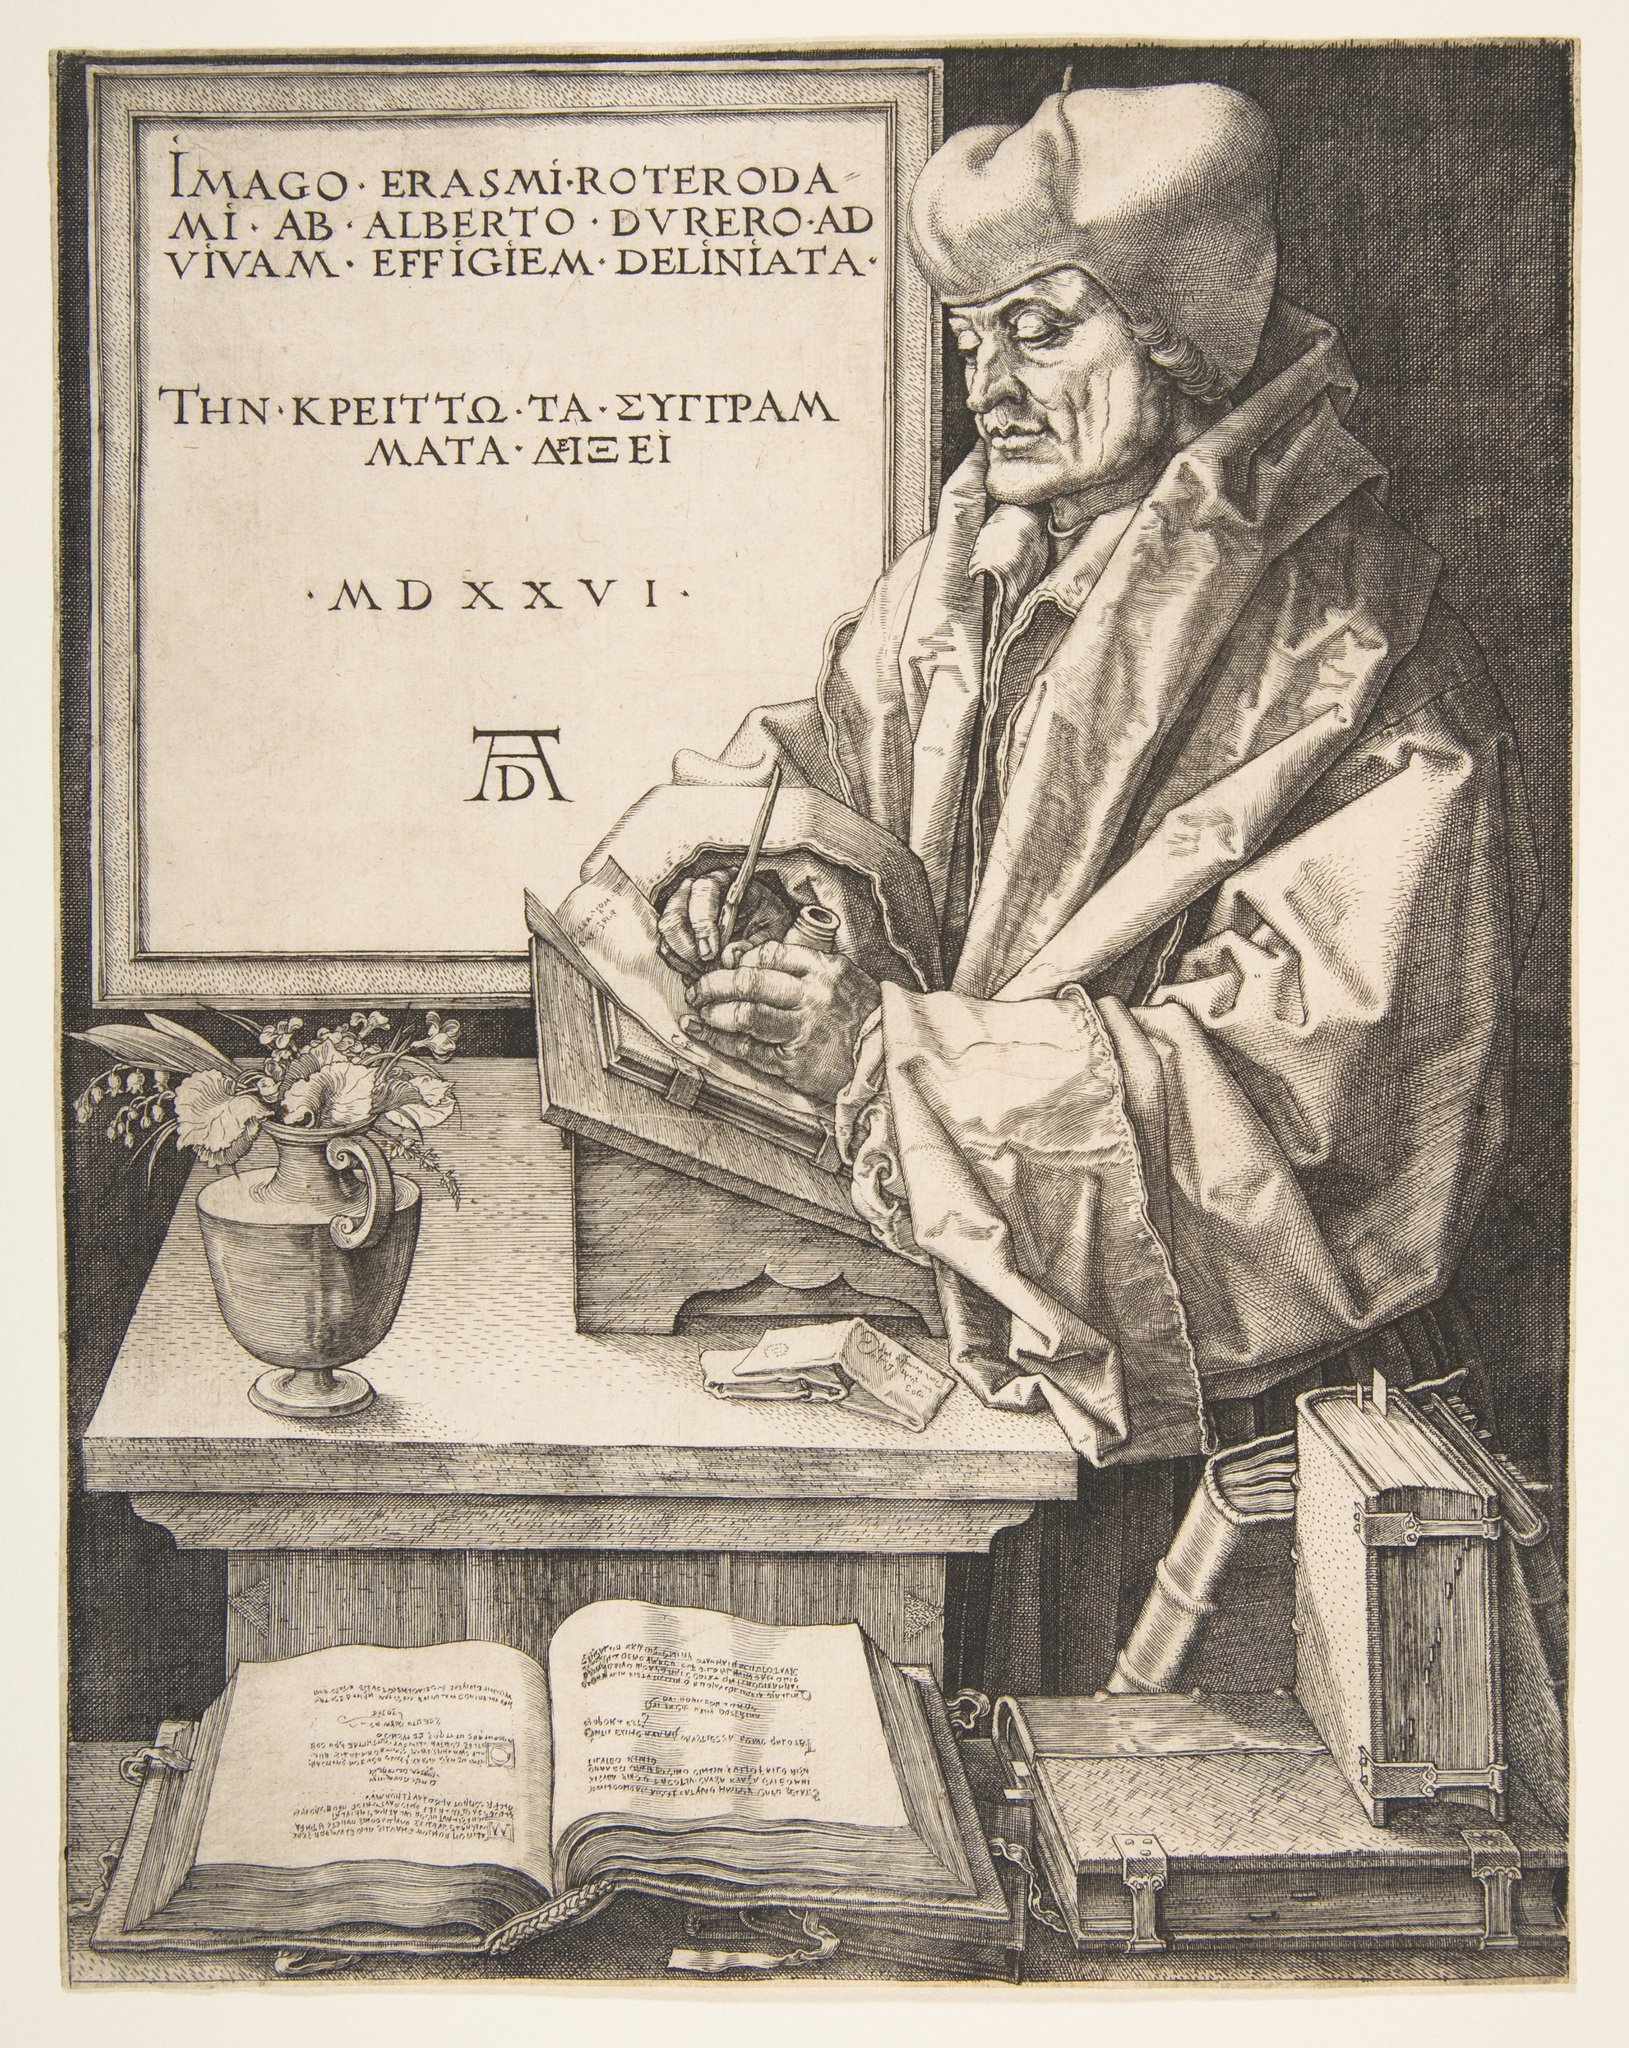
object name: print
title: Erasmus of Rotterdam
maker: albrecht dürer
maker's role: artist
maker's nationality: german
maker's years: 1471-1528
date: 1526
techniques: engraving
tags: books,men,writing